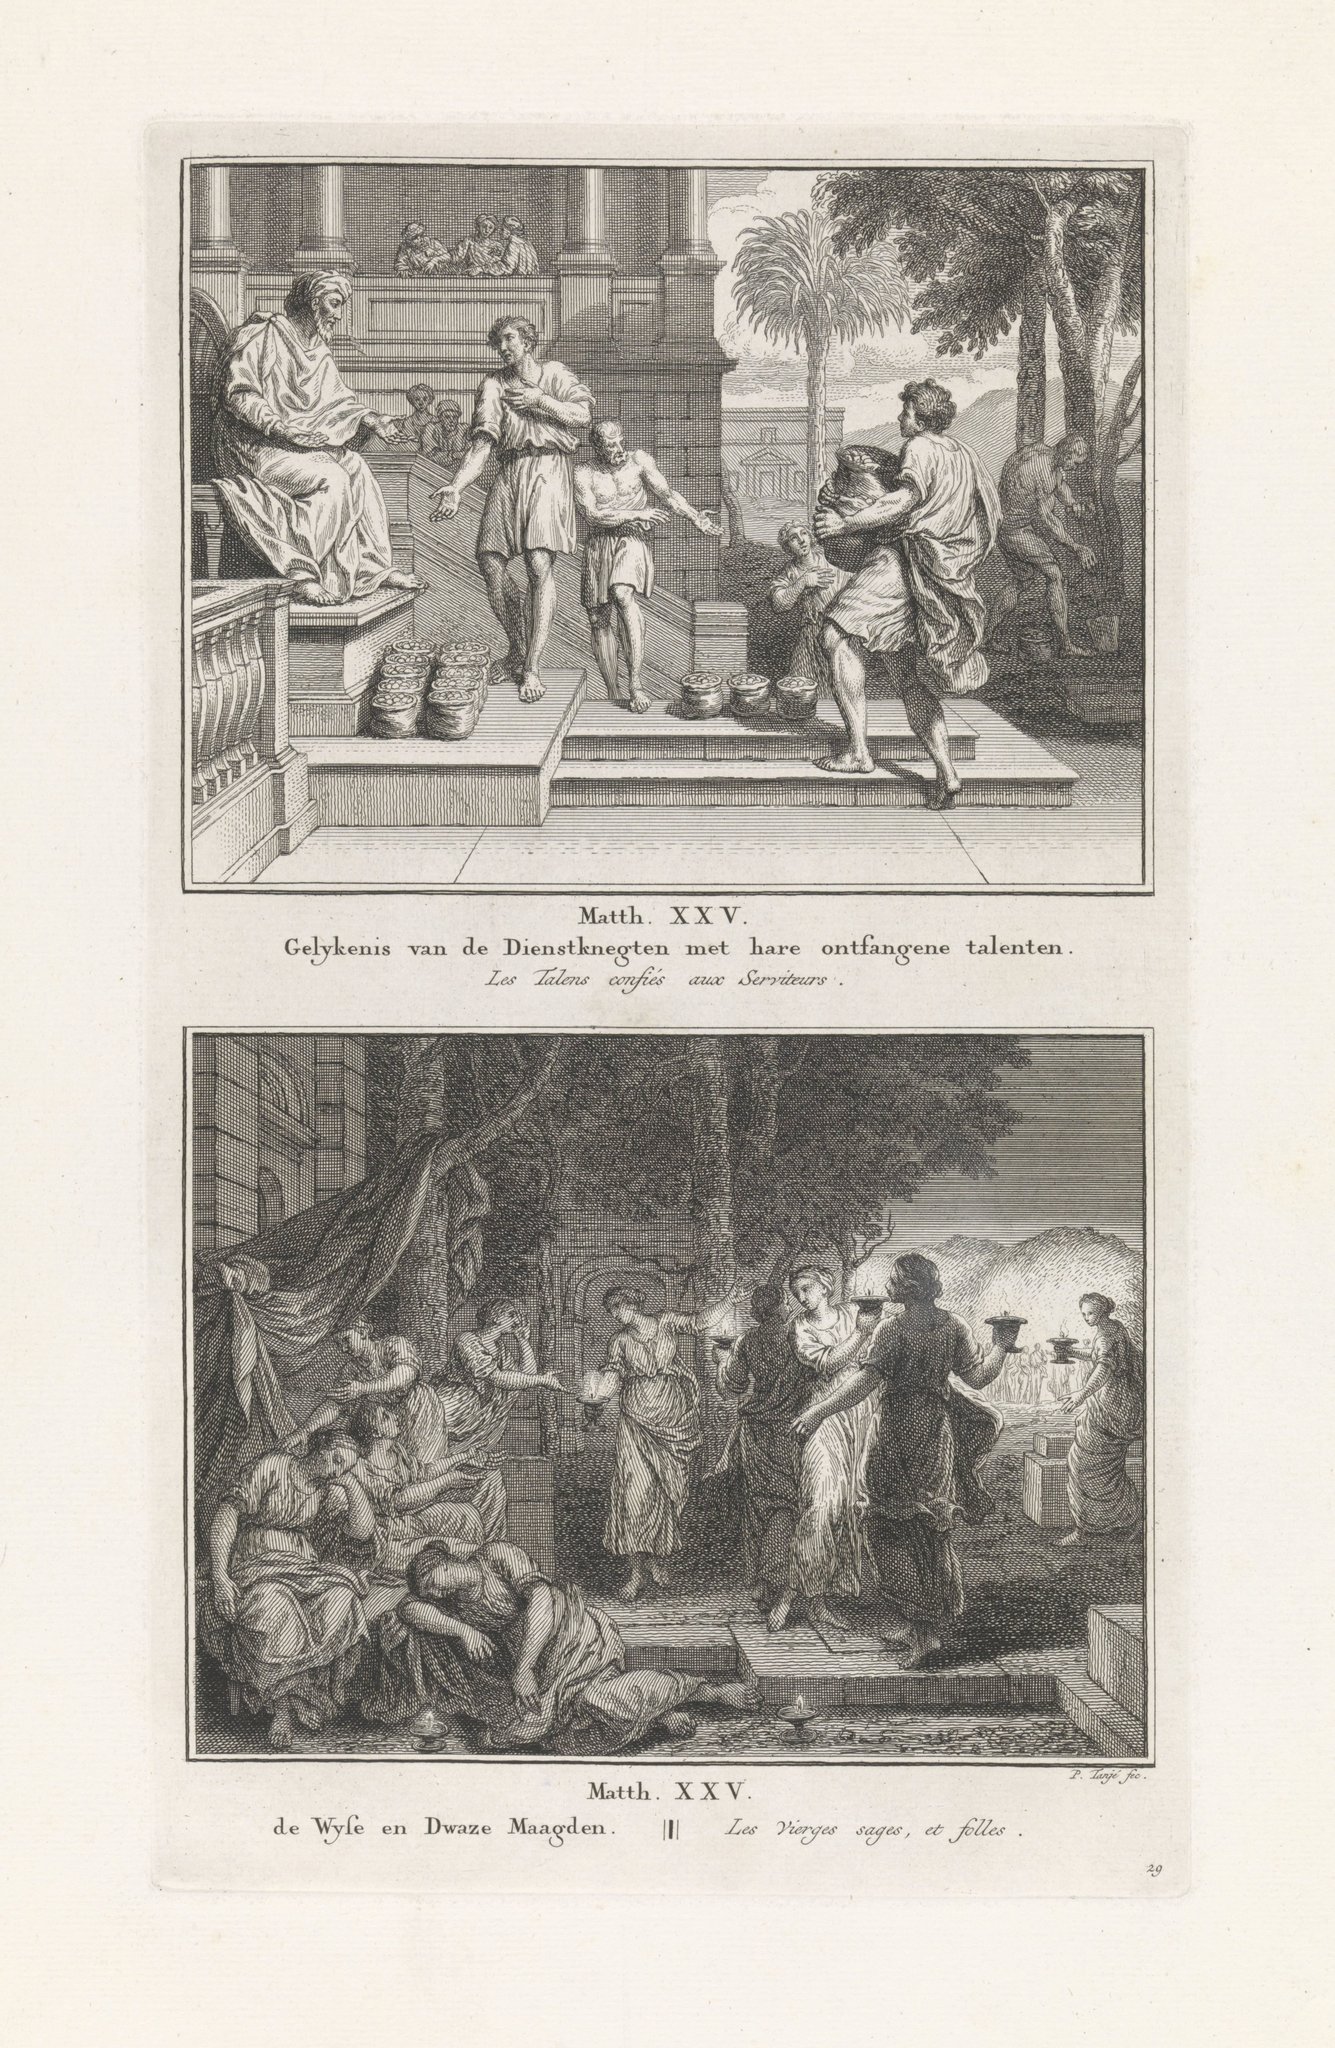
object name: book illustration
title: Gelykenis van de Dienstknegten met hare ontfangene talenten (...) / de Wijse en Dwaze Maagden (...)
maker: pieter tanjé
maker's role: draughtsman, print maker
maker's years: 1706-1761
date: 1716-1761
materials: paper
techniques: engraving, etching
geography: amsterdam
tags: the talents or pounds ~ parable of christ (matthew 25:14-30; luke 19:12-27), the wise and the foolish virgins ~ parable of christ (matthew 25:1-13)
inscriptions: collector's mark: Lugt 2233, collector's mark: Lugt 3937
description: Twee Bijbelse voorstellingen. Boven: Een heer op een troon vraagt zijn drie dienaren om rekenschap. Degenen met vijf talenten en twee talenten hebben allebei hetzelfde bedrag erbij verdiend. De laatste dienaar rechts brengt zijn zak met een talent en geeft de heer precies hetzelfde terug als wat hij gekregen had. Onder: De vijf wijze maagden steken met wat extra olie hun lampen aan en gaan op weg. De dwaze maagden slapen bij hun bijna gedoofde lampen. Onder de voorstellingen een verwijzing naar de Bijbelteksten en de titels in het Nederlands en Frans.